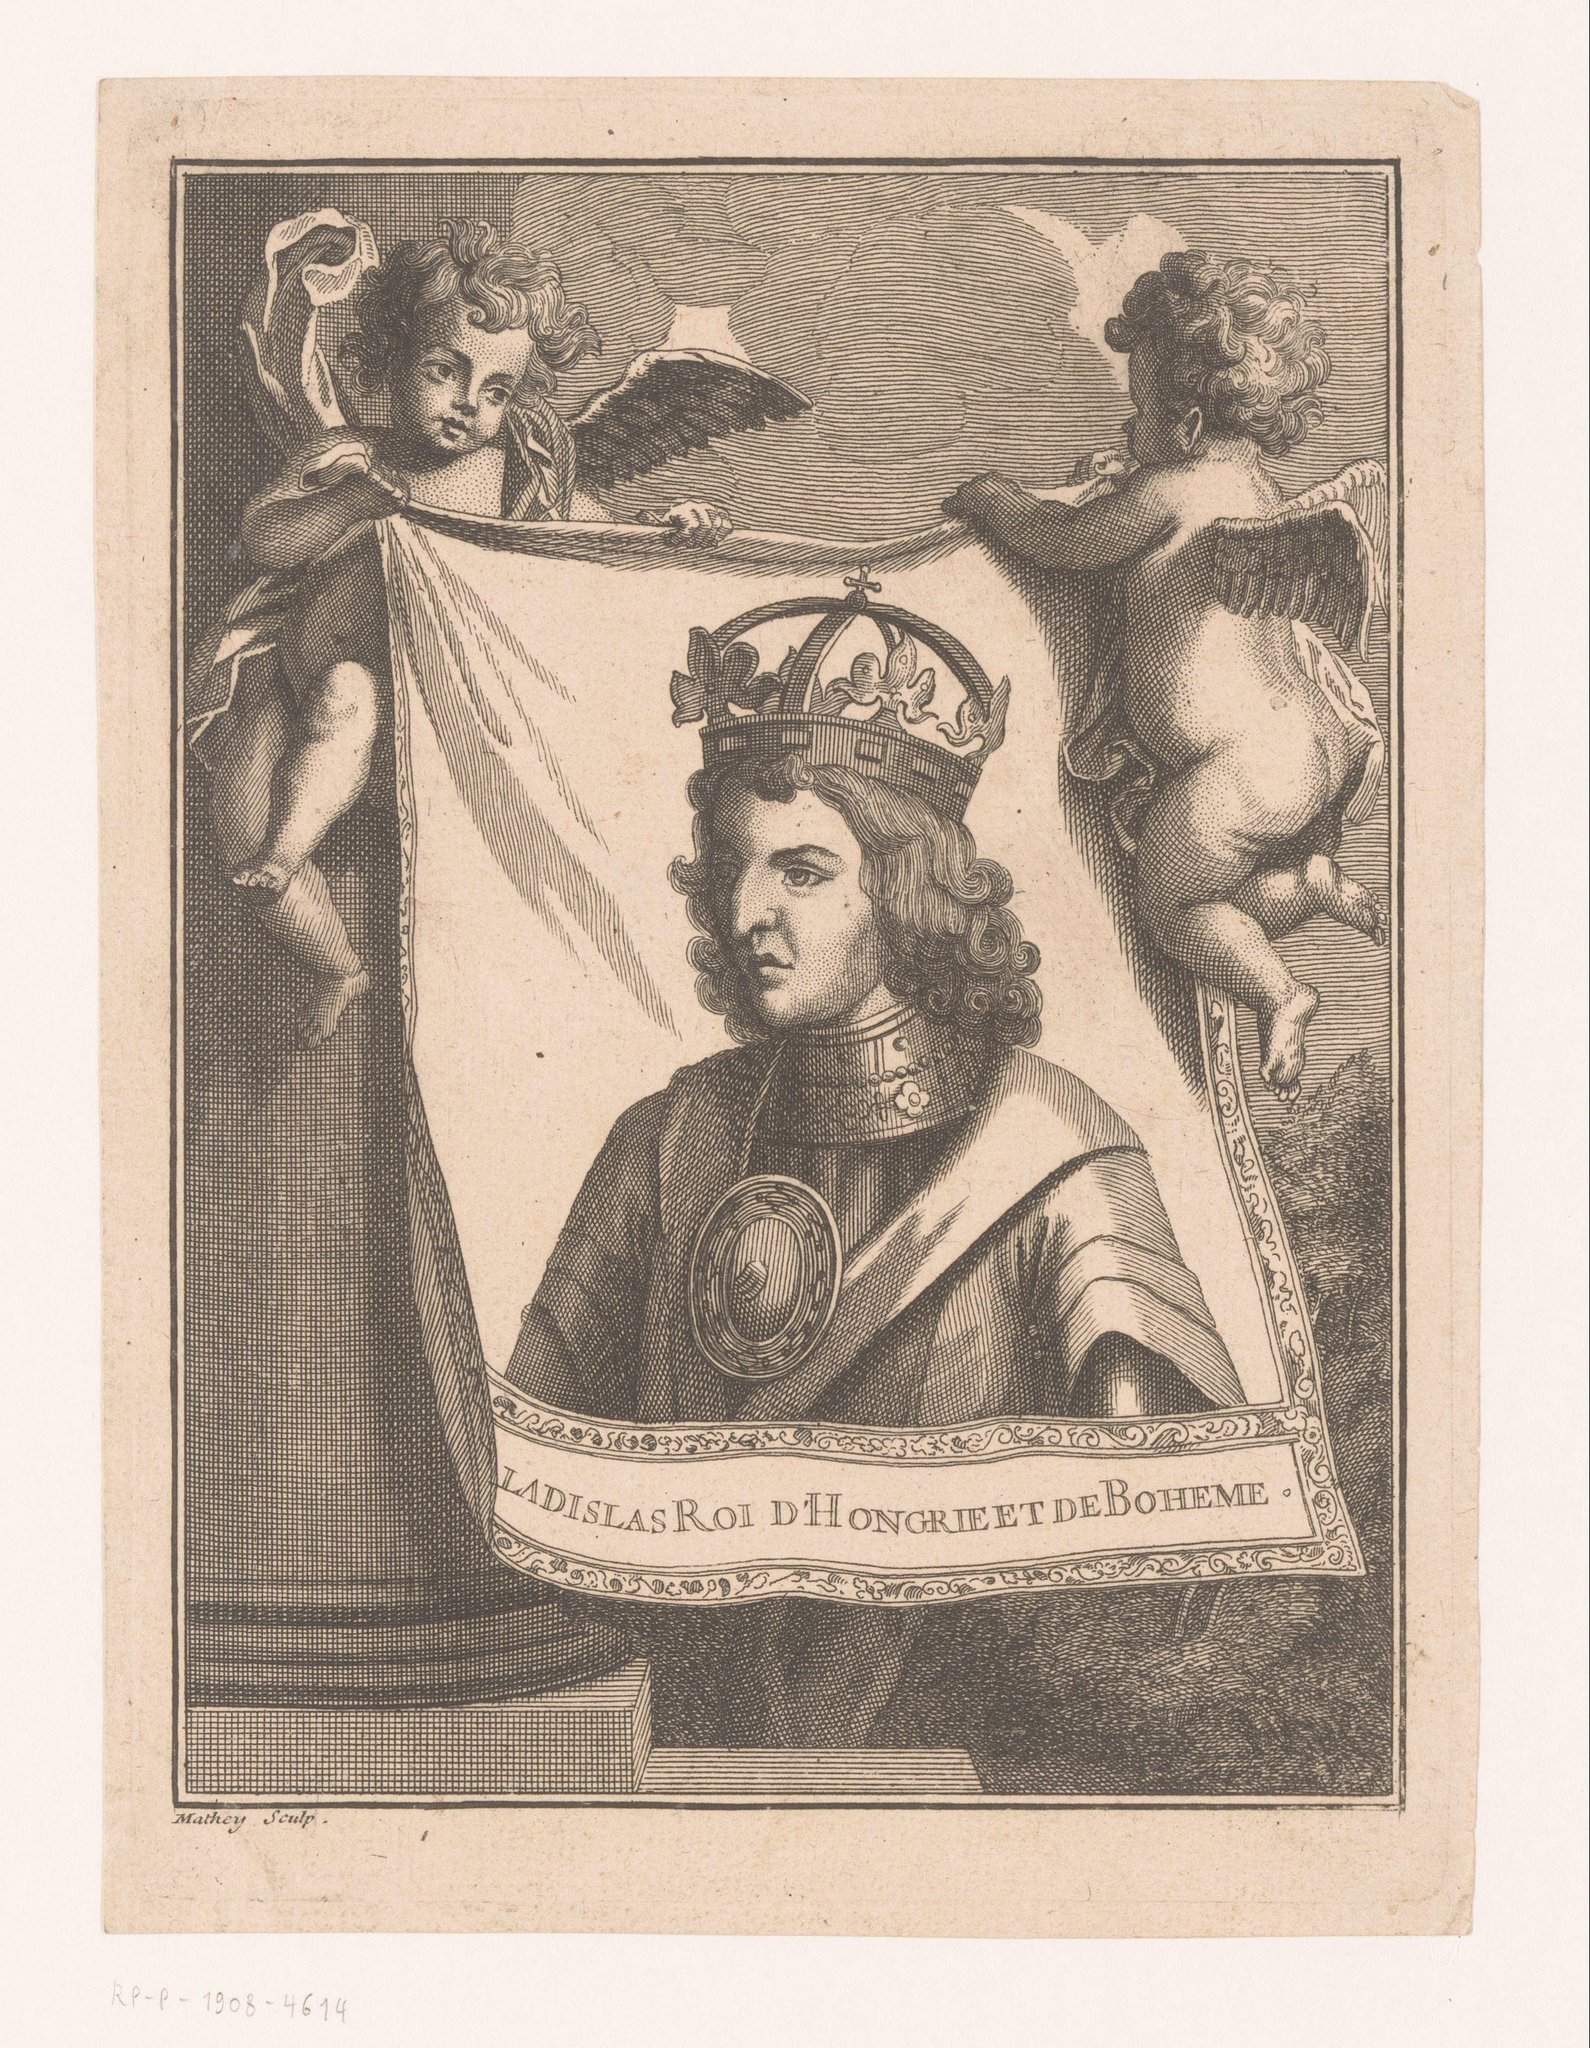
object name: print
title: Portret van Ladislaus I van Hongarije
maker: c. mathey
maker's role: print maker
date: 1700-1755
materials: paper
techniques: engraving, etching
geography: france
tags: poland, historical persons, ruler, sovereign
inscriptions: collector's mark: Lugt 2228